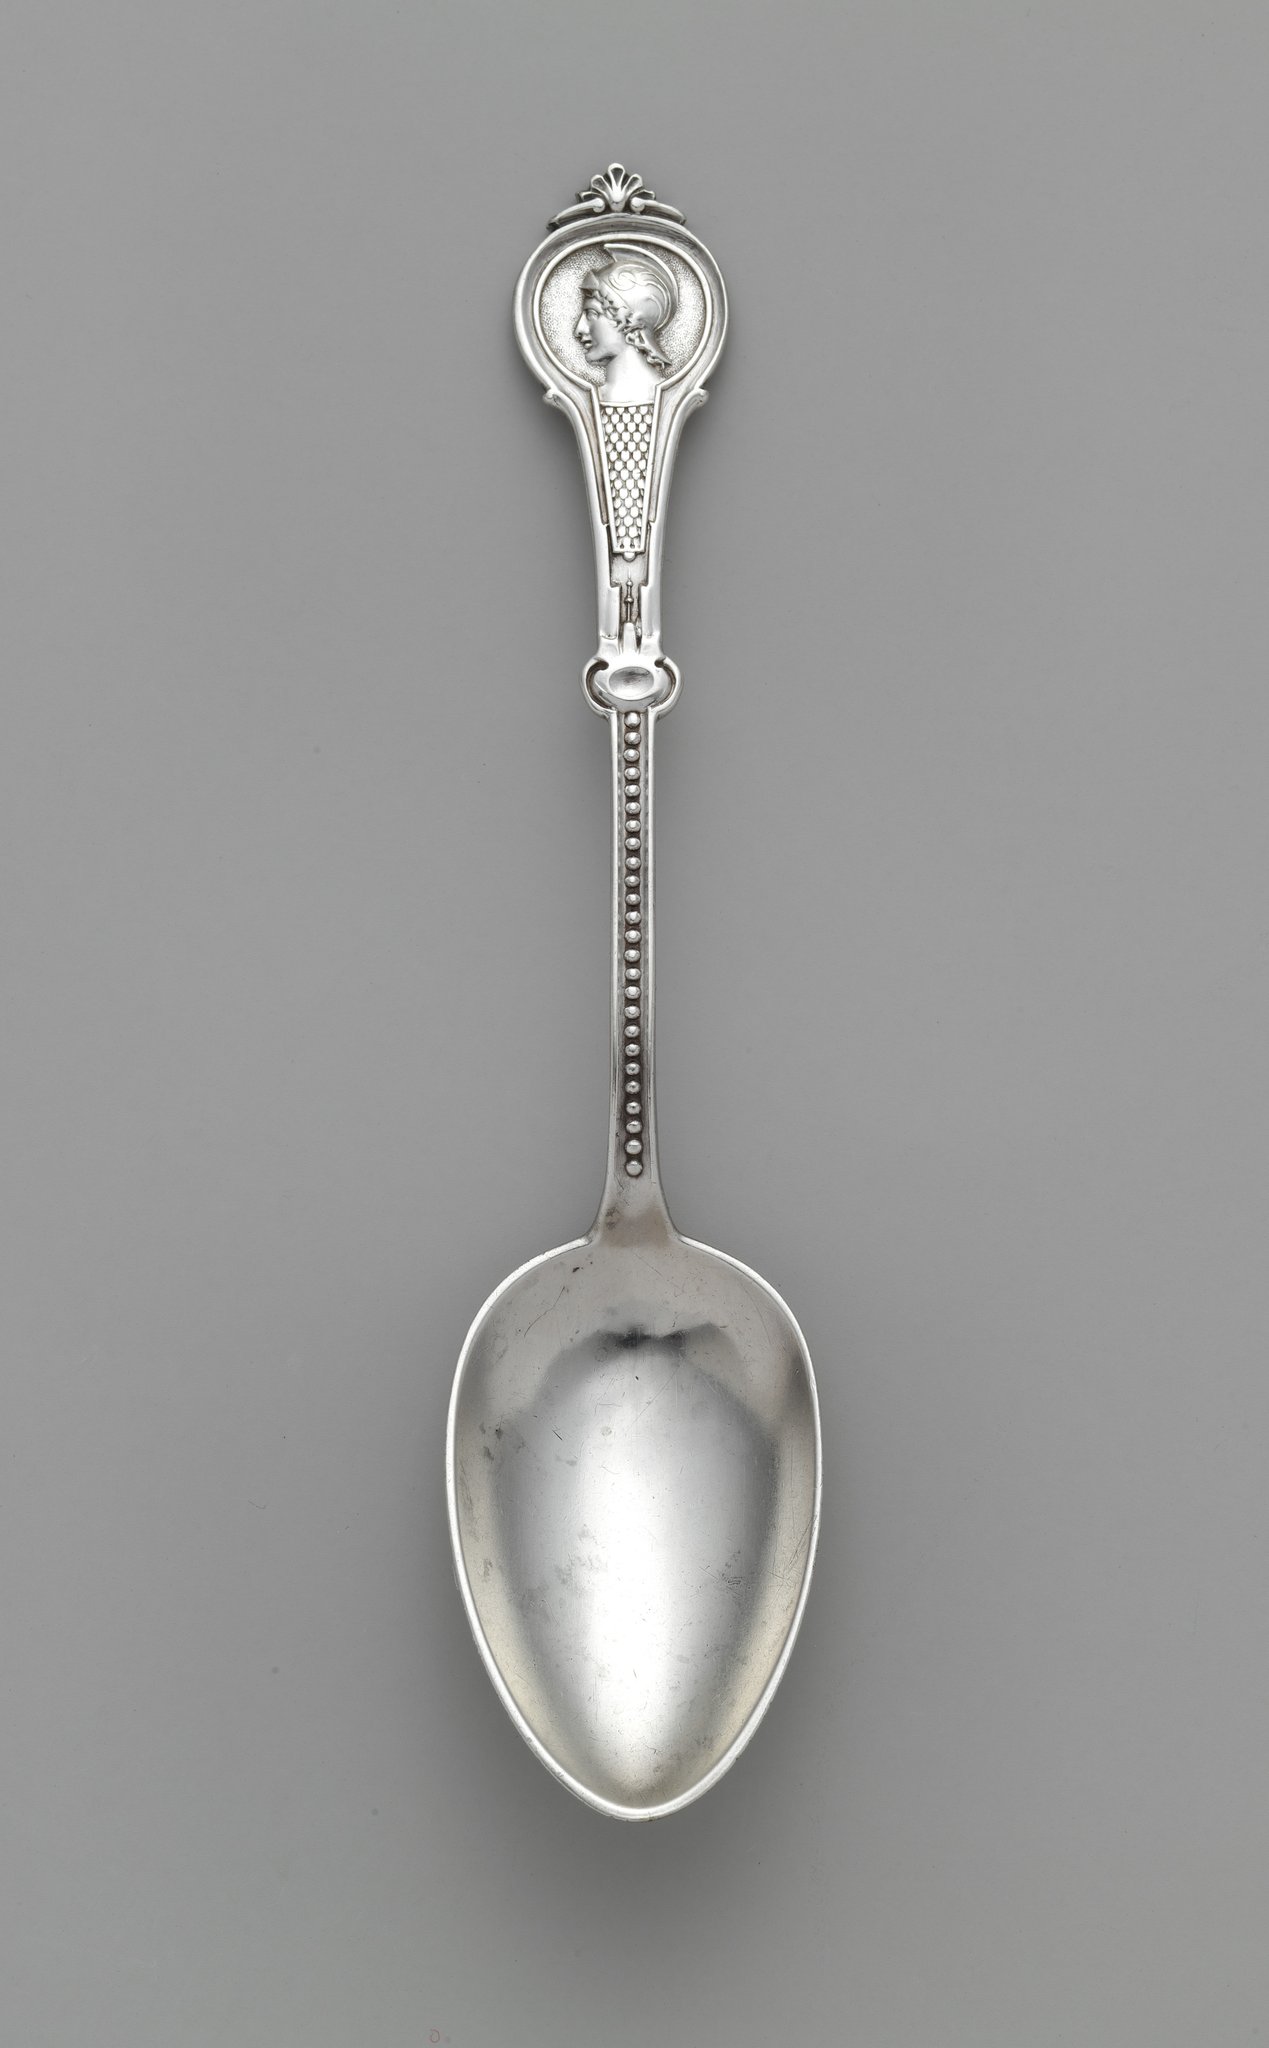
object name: spoon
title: Tea Spoon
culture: american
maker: wood and hughes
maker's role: maker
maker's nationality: american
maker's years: 1845-1899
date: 1870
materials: silver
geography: united states